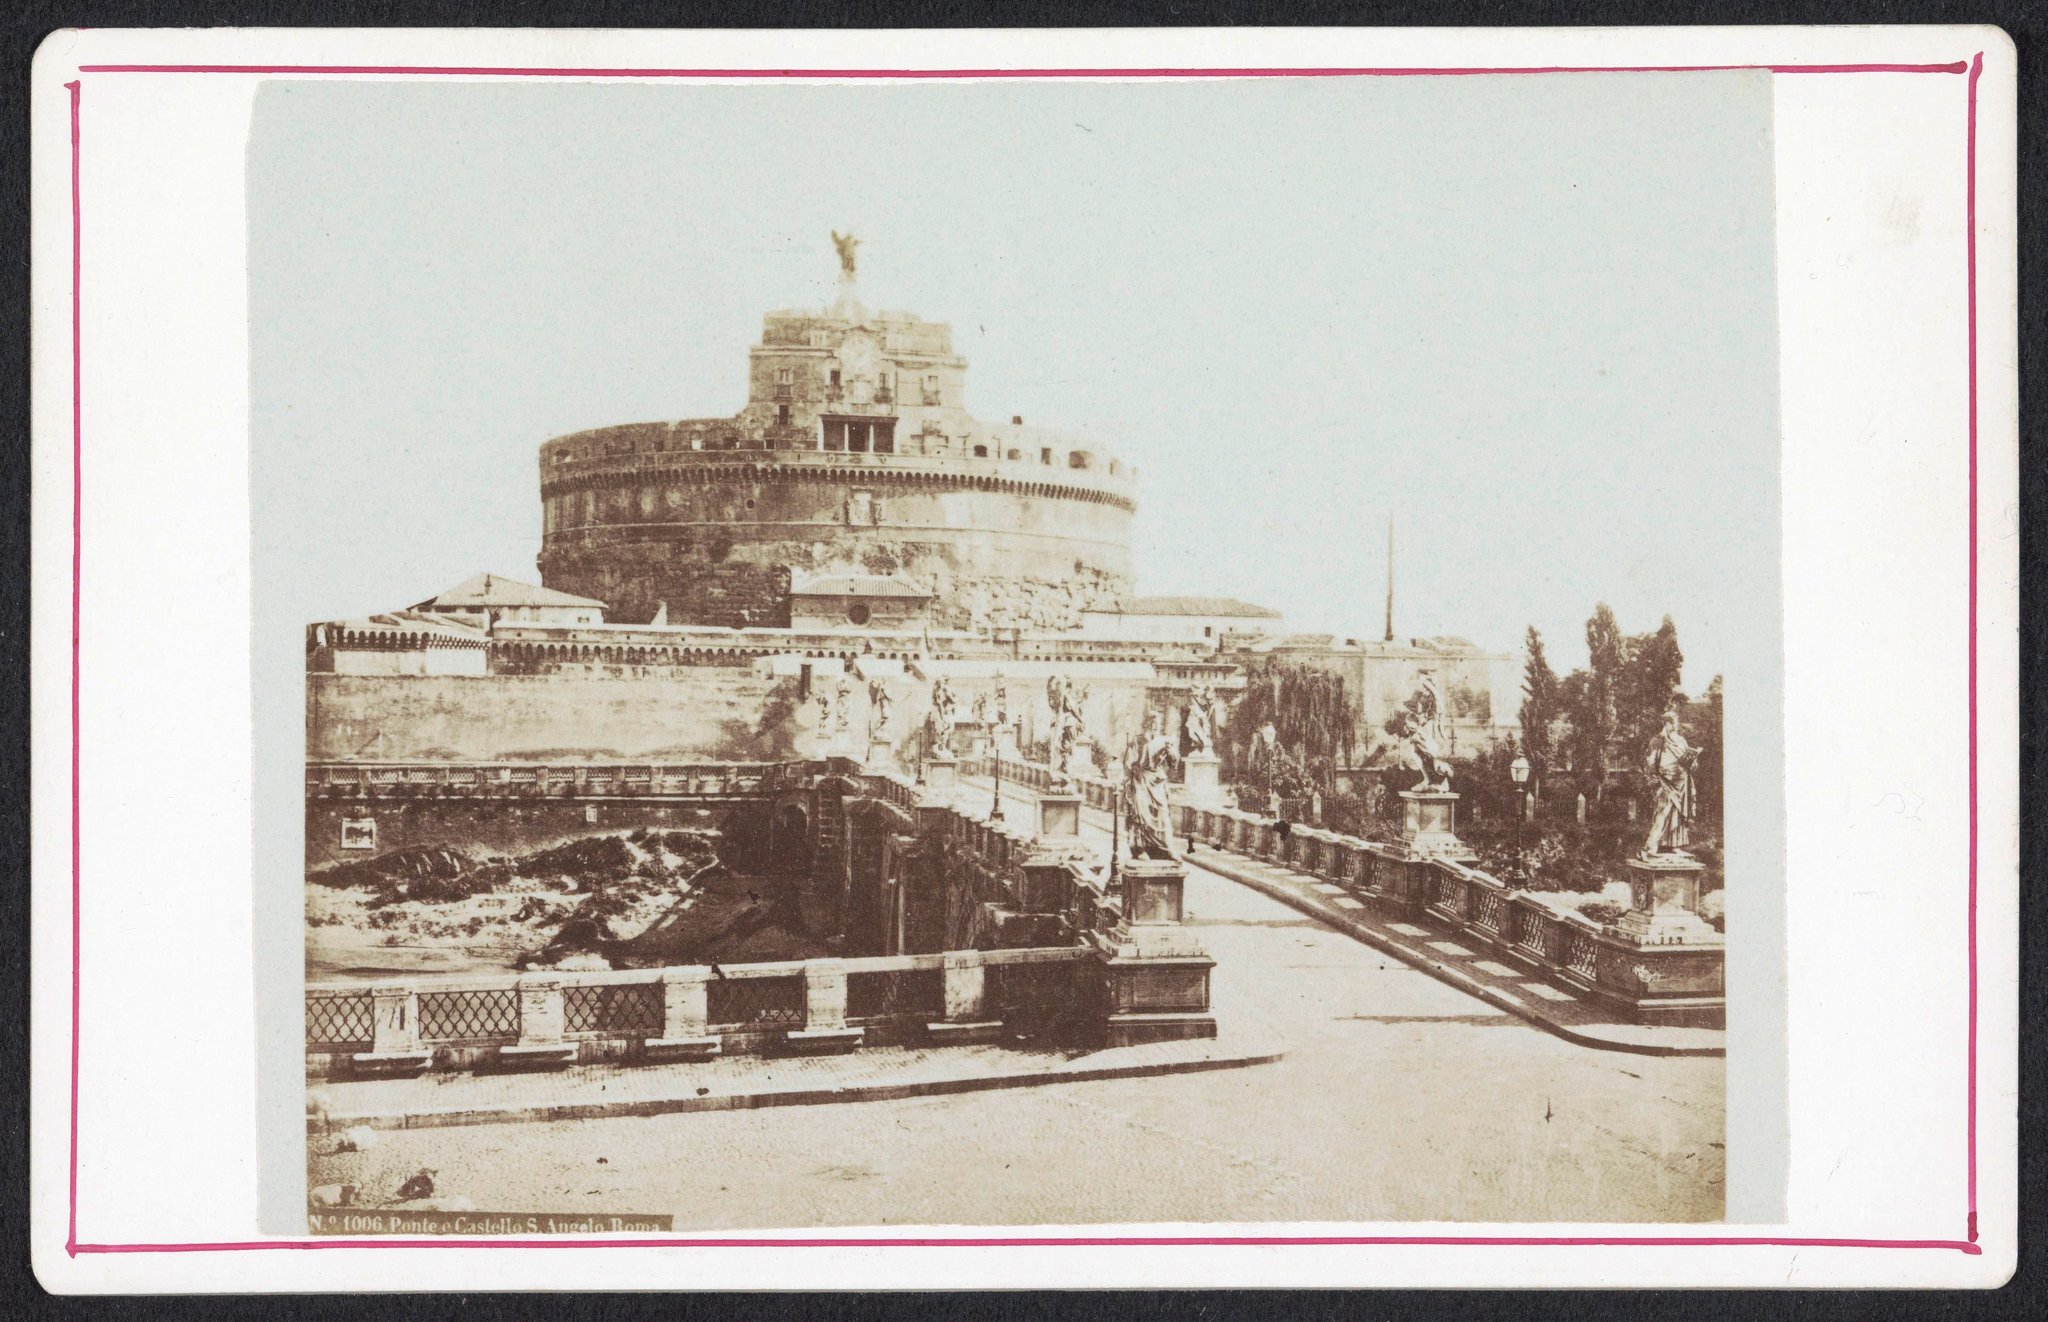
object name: cabinet photograph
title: Gezicht op de Engelenburcht in Rome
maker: Anonymous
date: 1850-1900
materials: cardboard, photographic support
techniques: albumen print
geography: engelenburcht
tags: parts of church exterior and annexes: chapel - qq - small church, chapel, monument, statue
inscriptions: annotation: ‘Roma/ [...]’